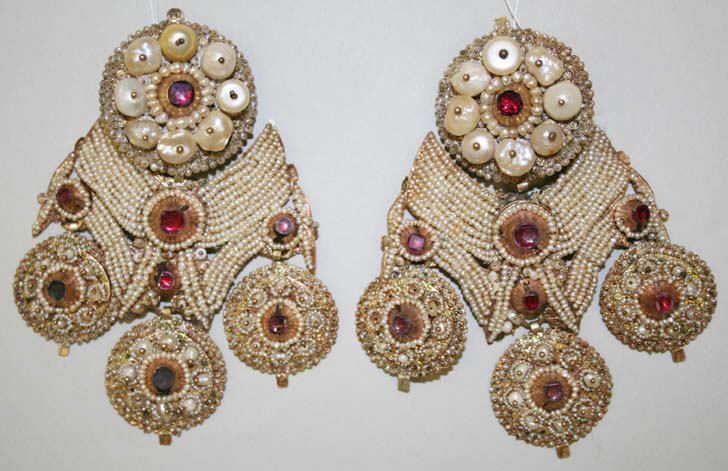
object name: earring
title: Earrings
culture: indian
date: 1801-1833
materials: pearl, silver